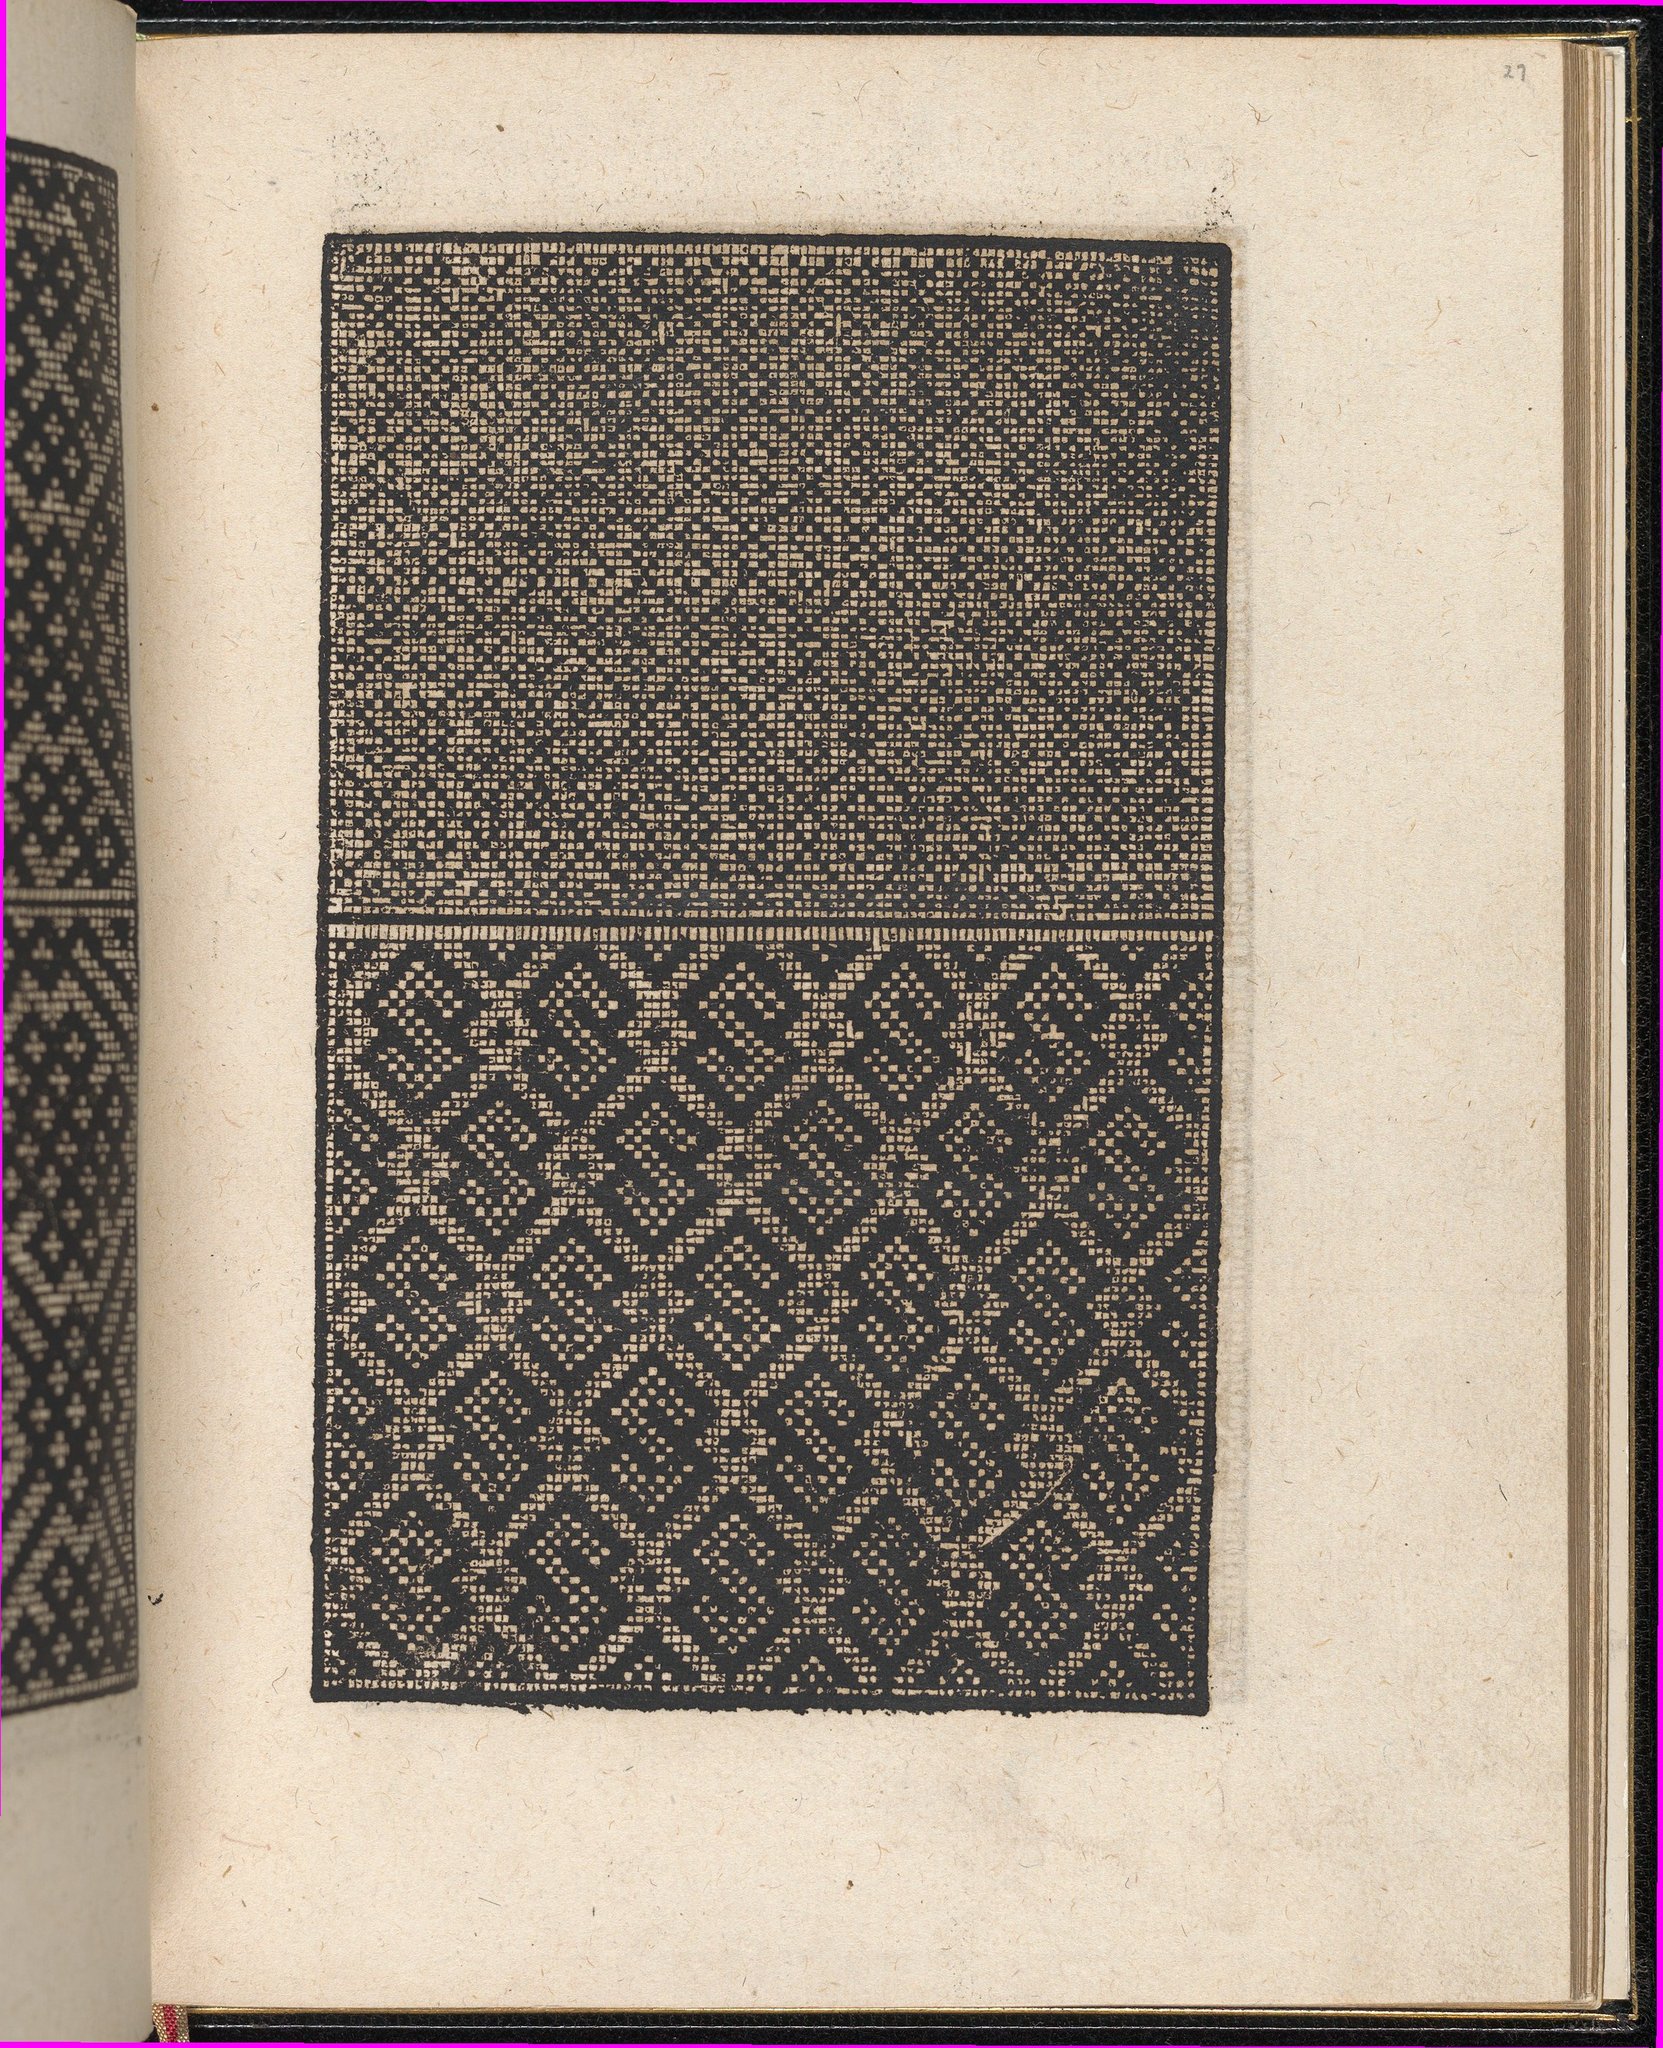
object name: book print ornament architecture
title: Page from Ein new kunstlich Modelbuch...(Page 27r)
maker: peter quentel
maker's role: publisher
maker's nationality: german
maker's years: 1500-1550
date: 1544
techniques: woodcut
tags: ornament